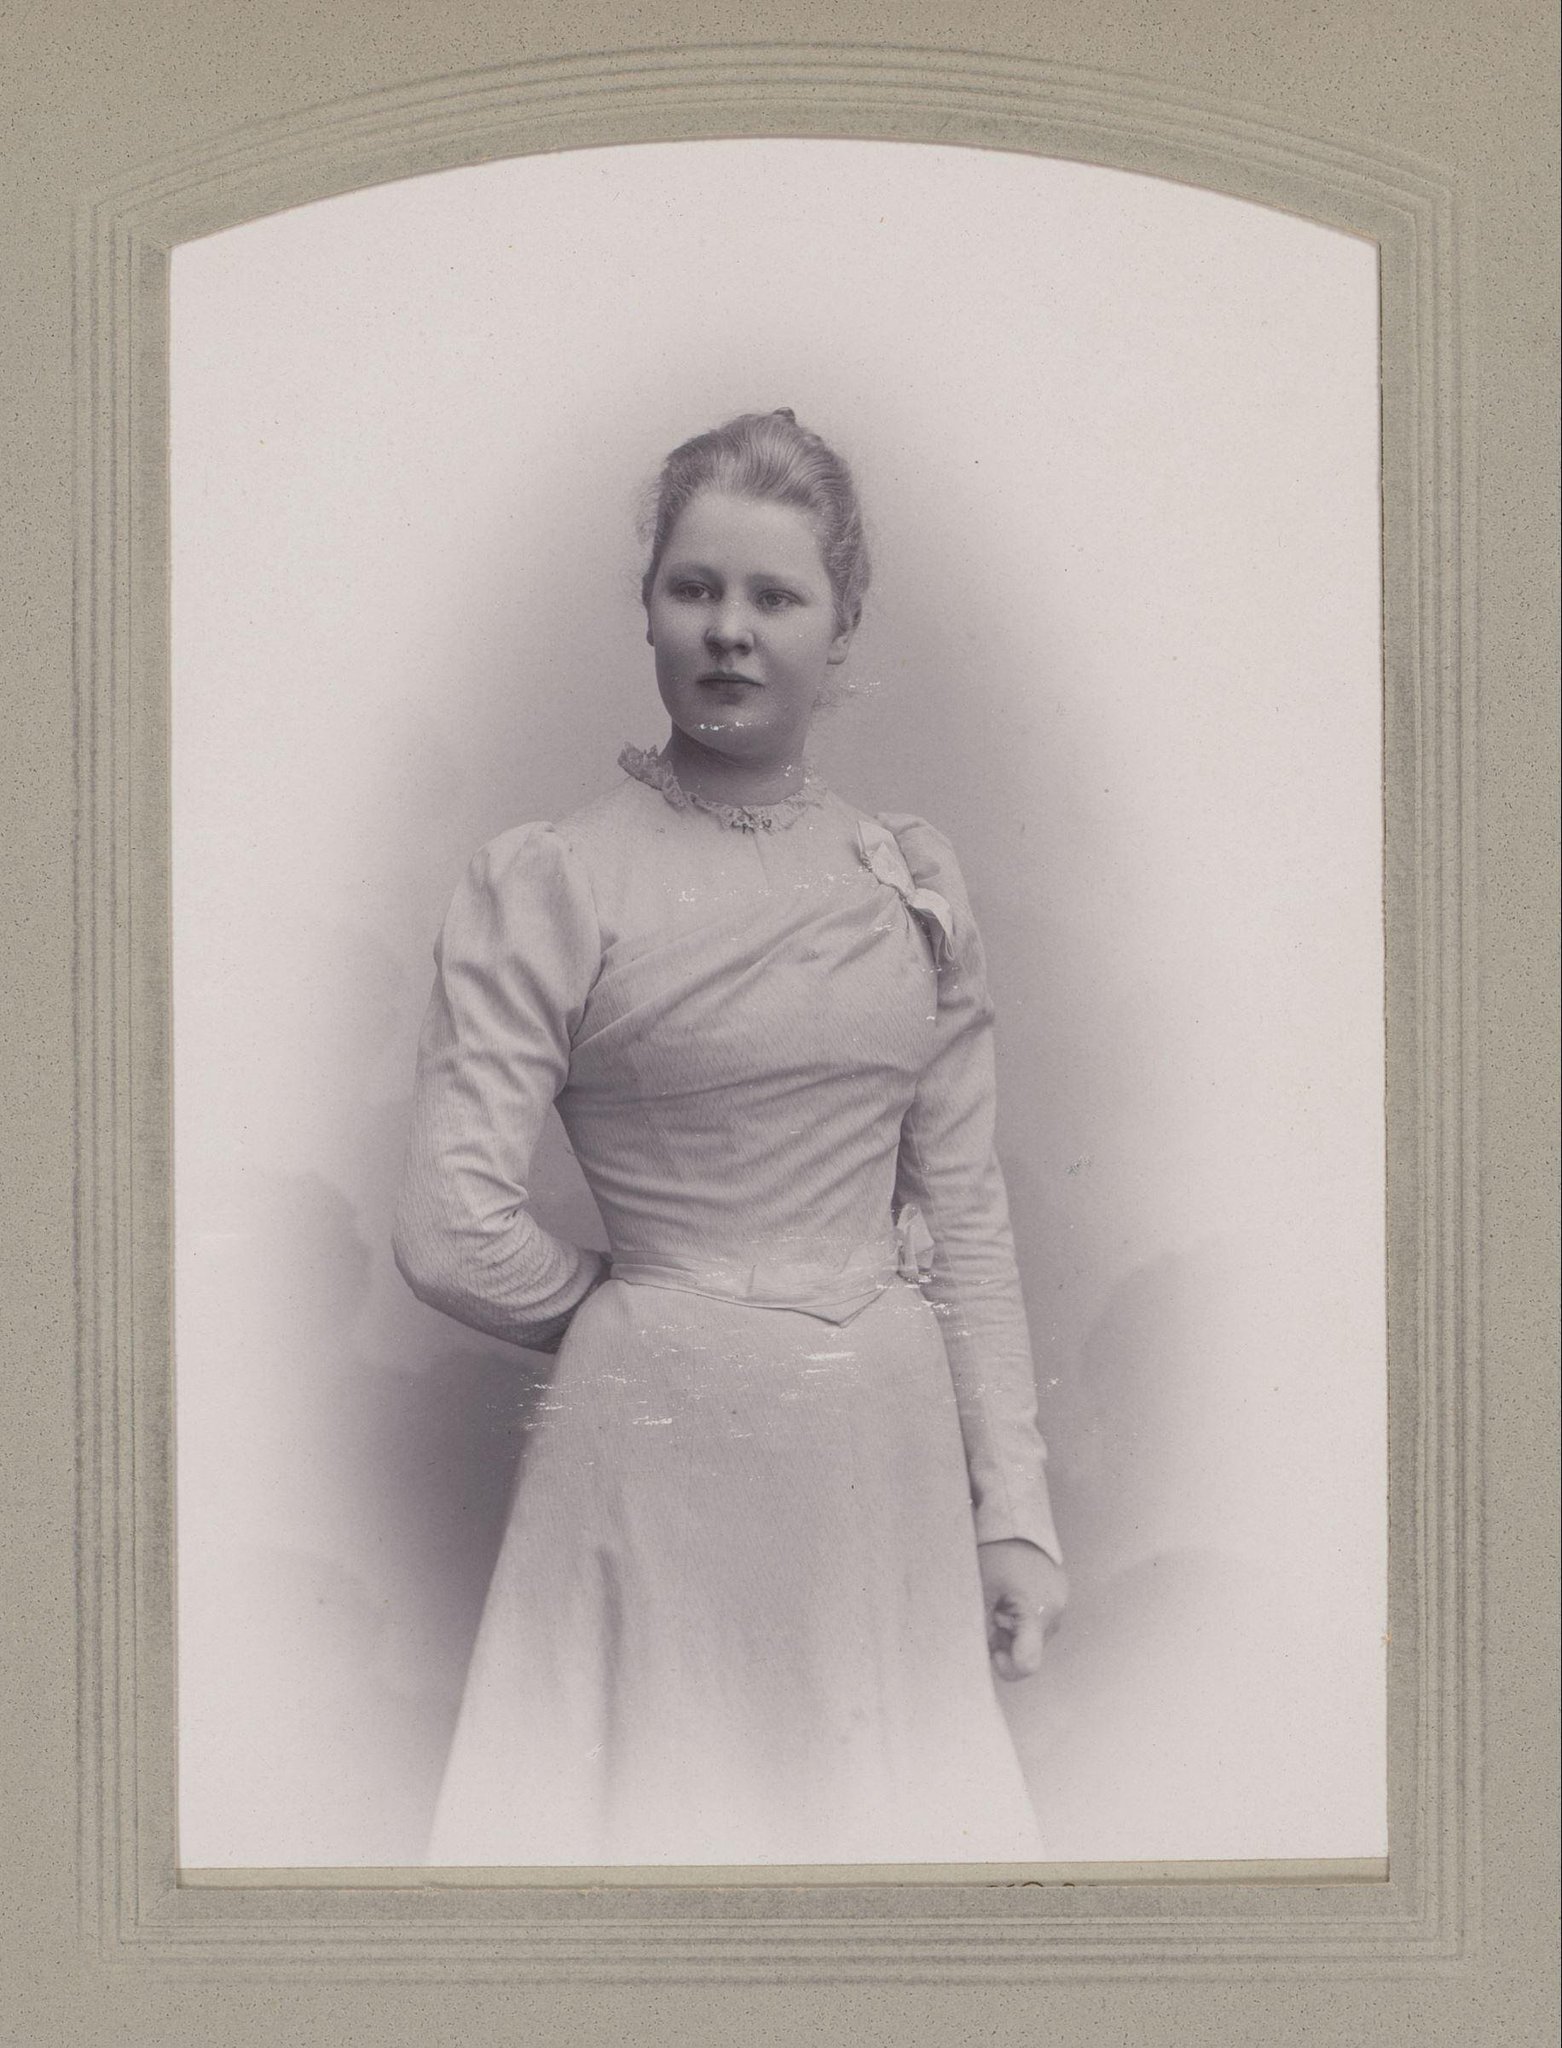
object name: album leaf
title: Portret van een staande jonge vrouw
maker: hedvig rosendahl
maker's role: fotograaf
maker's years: 1867-1929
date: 1880-1920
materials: cardboard, photographic support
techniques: collodion silver print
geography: stockholm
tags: adolescent, young woman, maiden, historical persons - bb - woman, standing figure - aa - female human figure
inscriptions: inscription: ‘Hedvig Rosendahls/ Atelier/ Stockholm/ Allm. Telef./ 42/ 10778/ Drotninggatan/ Allm. Telef./ & 51/ 11087/ Malmskilnadsgatan 48 c/ Allm. Tel. 6290./ Plåten förvaras för efterbeställning.’